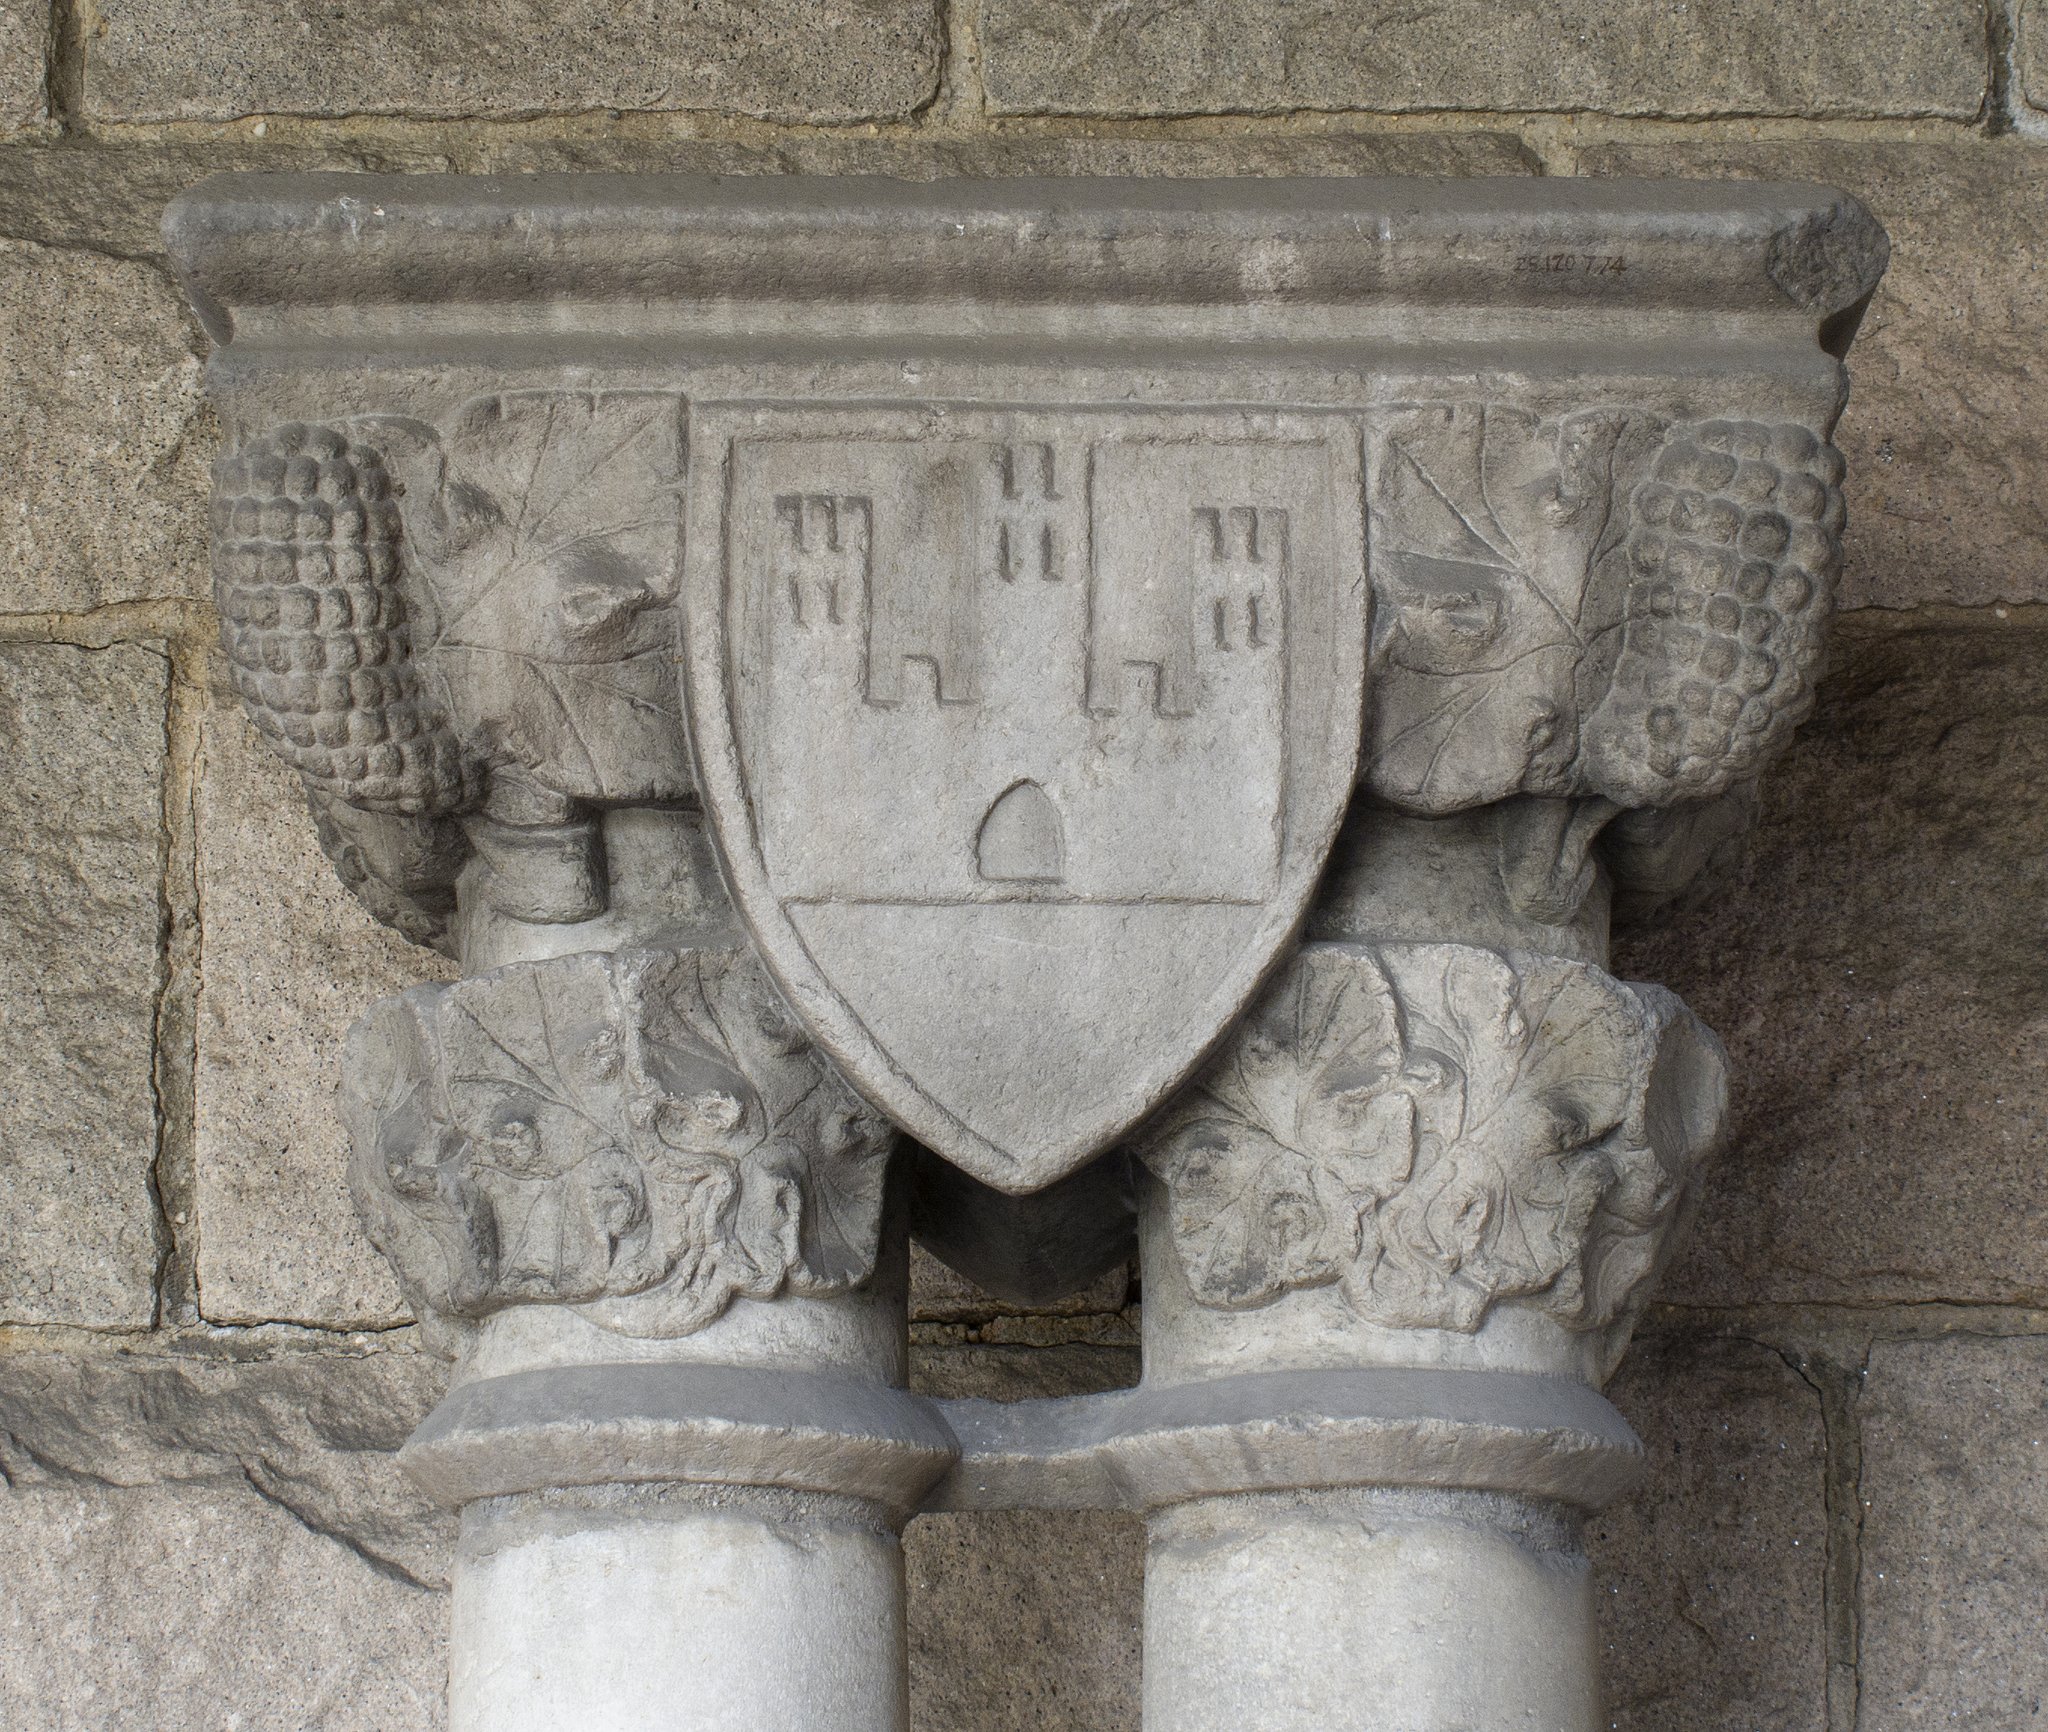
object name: capital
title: Double Capital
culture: french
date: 1267-1333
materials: marble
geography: france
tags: coat of arms